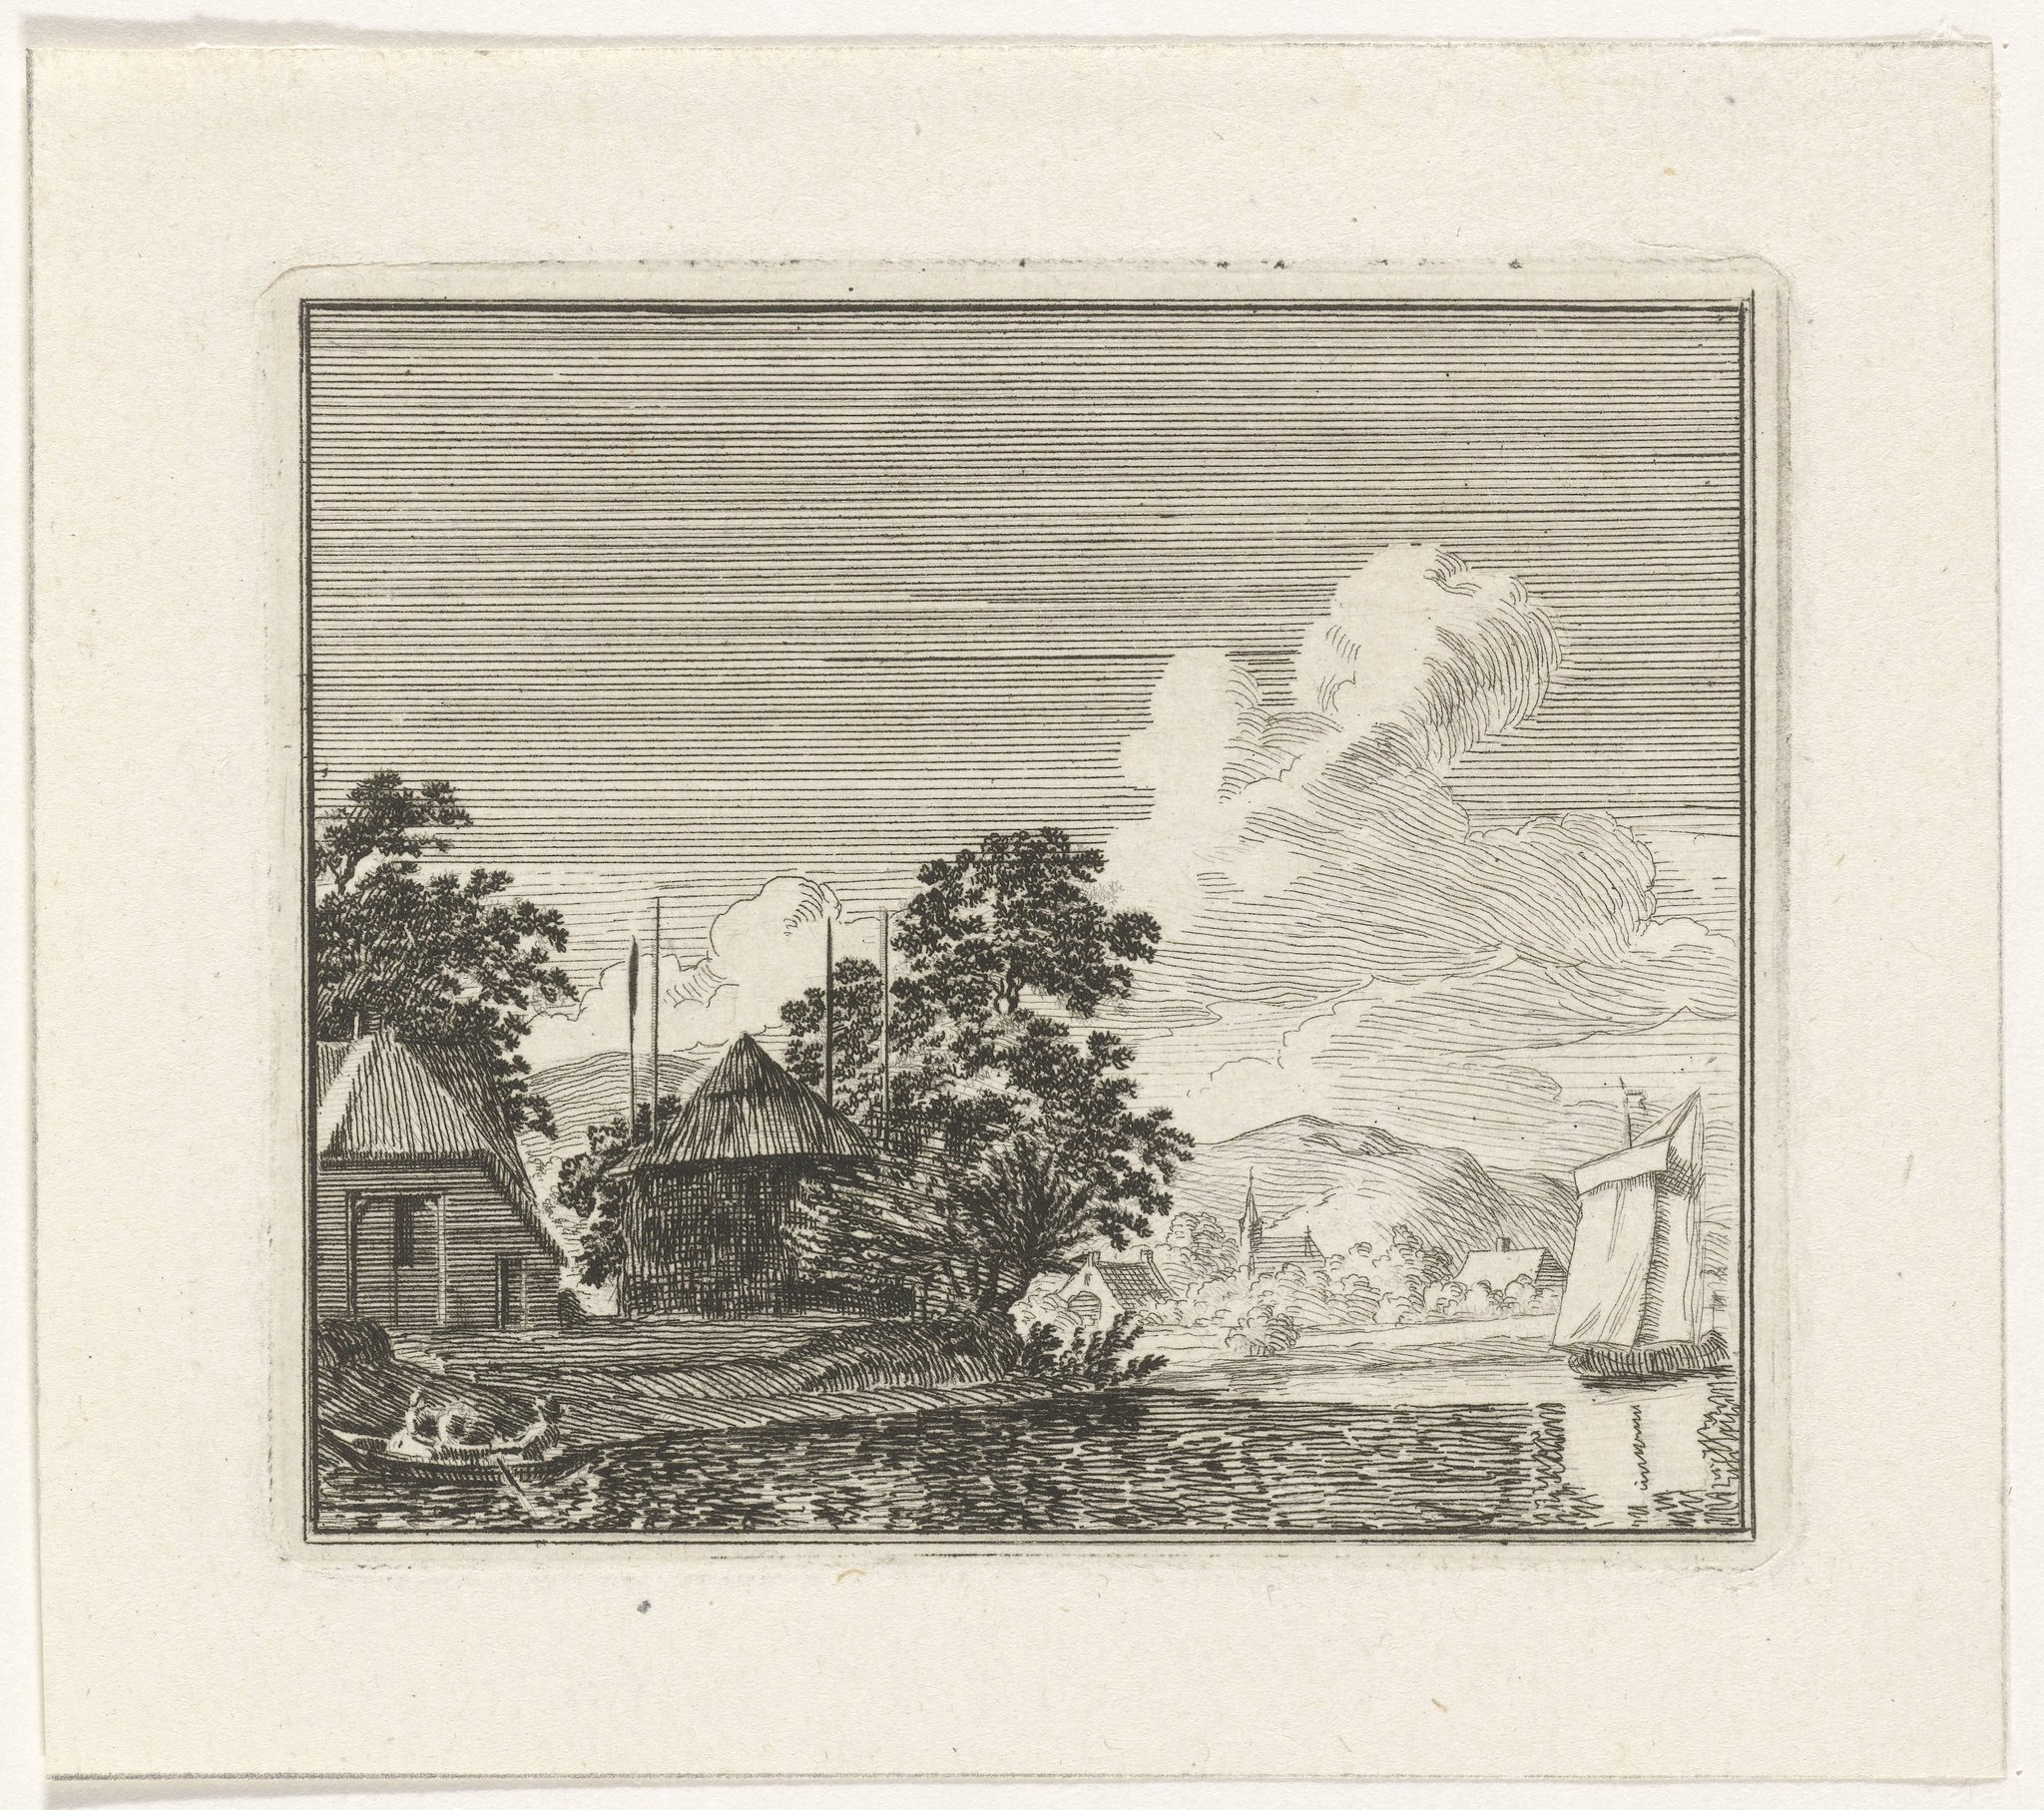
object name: print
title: Riviergezicht met een hooiberg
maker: hendrik hoogers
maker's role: draughtsman, mayor, print maker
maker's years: 1747-1814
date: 1757-1814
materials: paper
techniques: etching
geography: nijmegen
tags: hay-stack, landscapes with waters, waterscapes, seascapes (in the temperate zone) (+ landscape with figures, staffage), farm or solitary house in landscape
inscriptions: collector's mark: Lugt 2228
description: Rivierlandschap met links een boerderij en een hooiberg. Rechts een zeilschip.